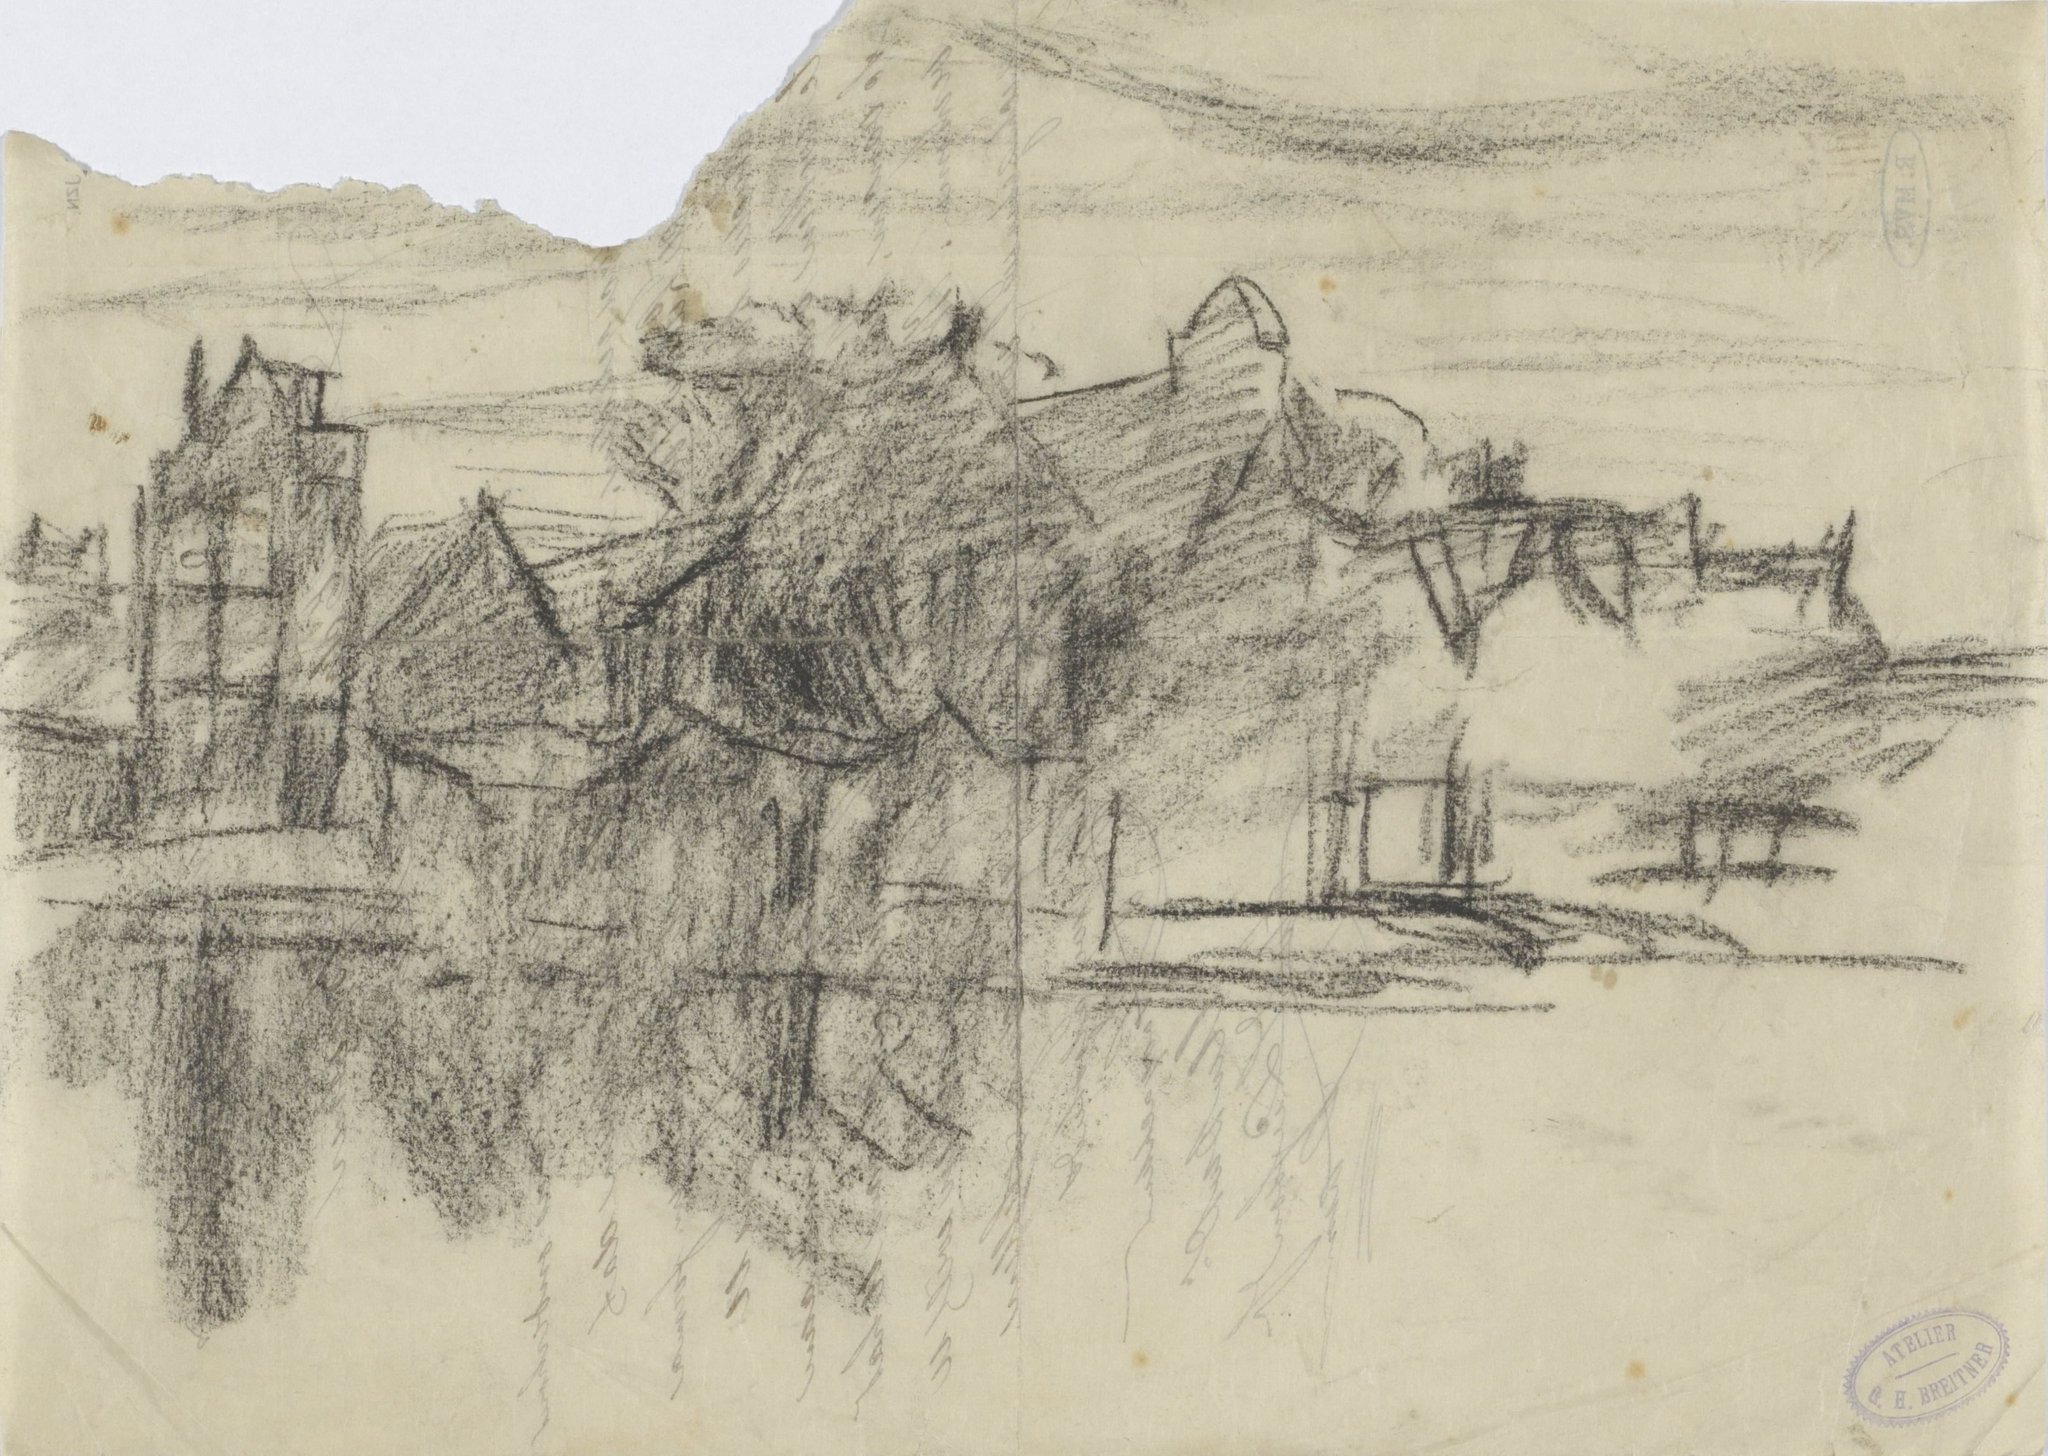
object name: drawing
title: Gezicht op de Nieuwe Teertuinen te Amsterdam, gezien vanaf Prinseneiland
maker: george hendrik breitner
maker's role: draughtsman, painter, print maker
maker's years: 1857-1923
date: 1901-1914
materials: chalk, paper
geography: amsterdam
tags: canals, waters (in city), civic architecture; edifices; dwellings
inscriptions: collector's mark: Lugt 2228, workshop stamp: Lugt 291d, annotation: ‘Amsterdam, Juli '01/ Den Weledelgeb. Heer Breitner/ Heer!/ Naar aanleiding van ons onderhoud/ tijd geleden, waarbij wij U mede deelden dat/ de Leeuw toestond dat U in de fabr. van gen. firma/ studies kon verrichten, verzoekt genaamde heer ons U/ te willen vragen wanneer U van plan zijt hiermede aan/ te vangen, aangezien hij tot heden niets verder van U had/ vernomen. Wij voldoen hiermede aan dat verzoek en wilt u/ zich zeker wel verder met gen. heer in verbinding stellen./ [...]/ H.J. Leefsond[...]’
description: Nieuwe Teertuinen 13 t/m 33 (van rechts naar links). Vooraan de Prinseneilandsgracht. Verso een brief aan Breitner.